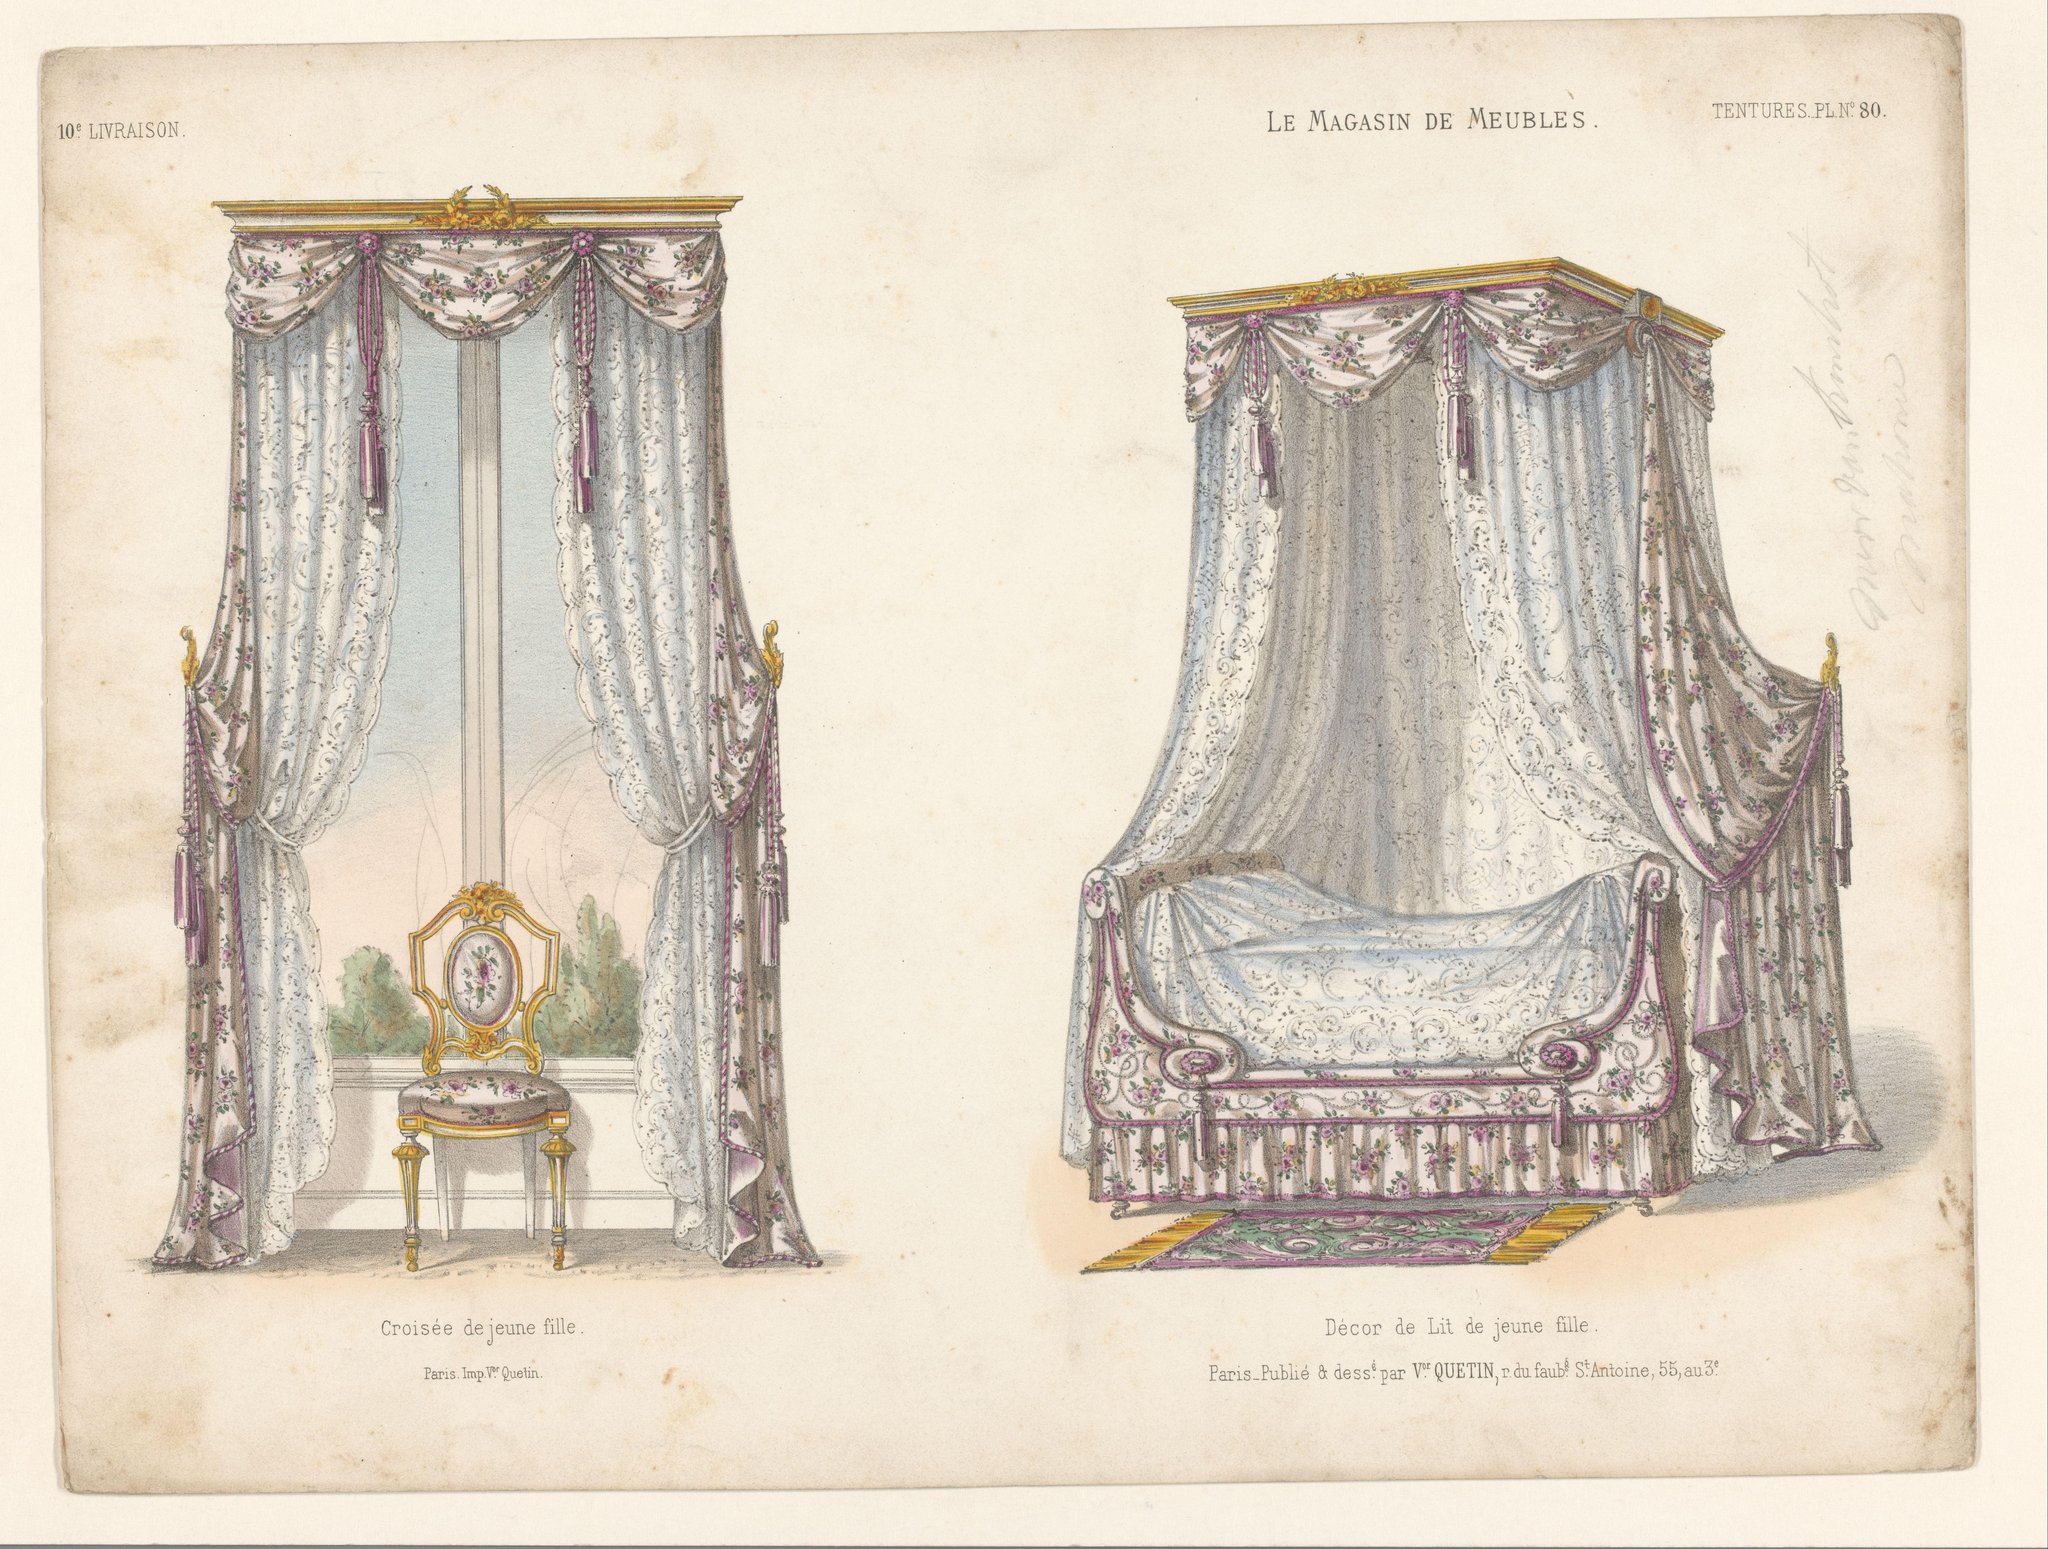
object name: print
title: Croisée de jeune fille / Décor de Lit de jeune fille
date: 1832-1877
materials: paper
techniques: hand coloring, lithograph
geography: paris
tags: window, bed with tester, hangings and drapery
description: Een venster met gedrapeerde gordijnen en een hemelbed met draperieën. Voor het venster staat een stoel. Prent uit 10e Livraison.